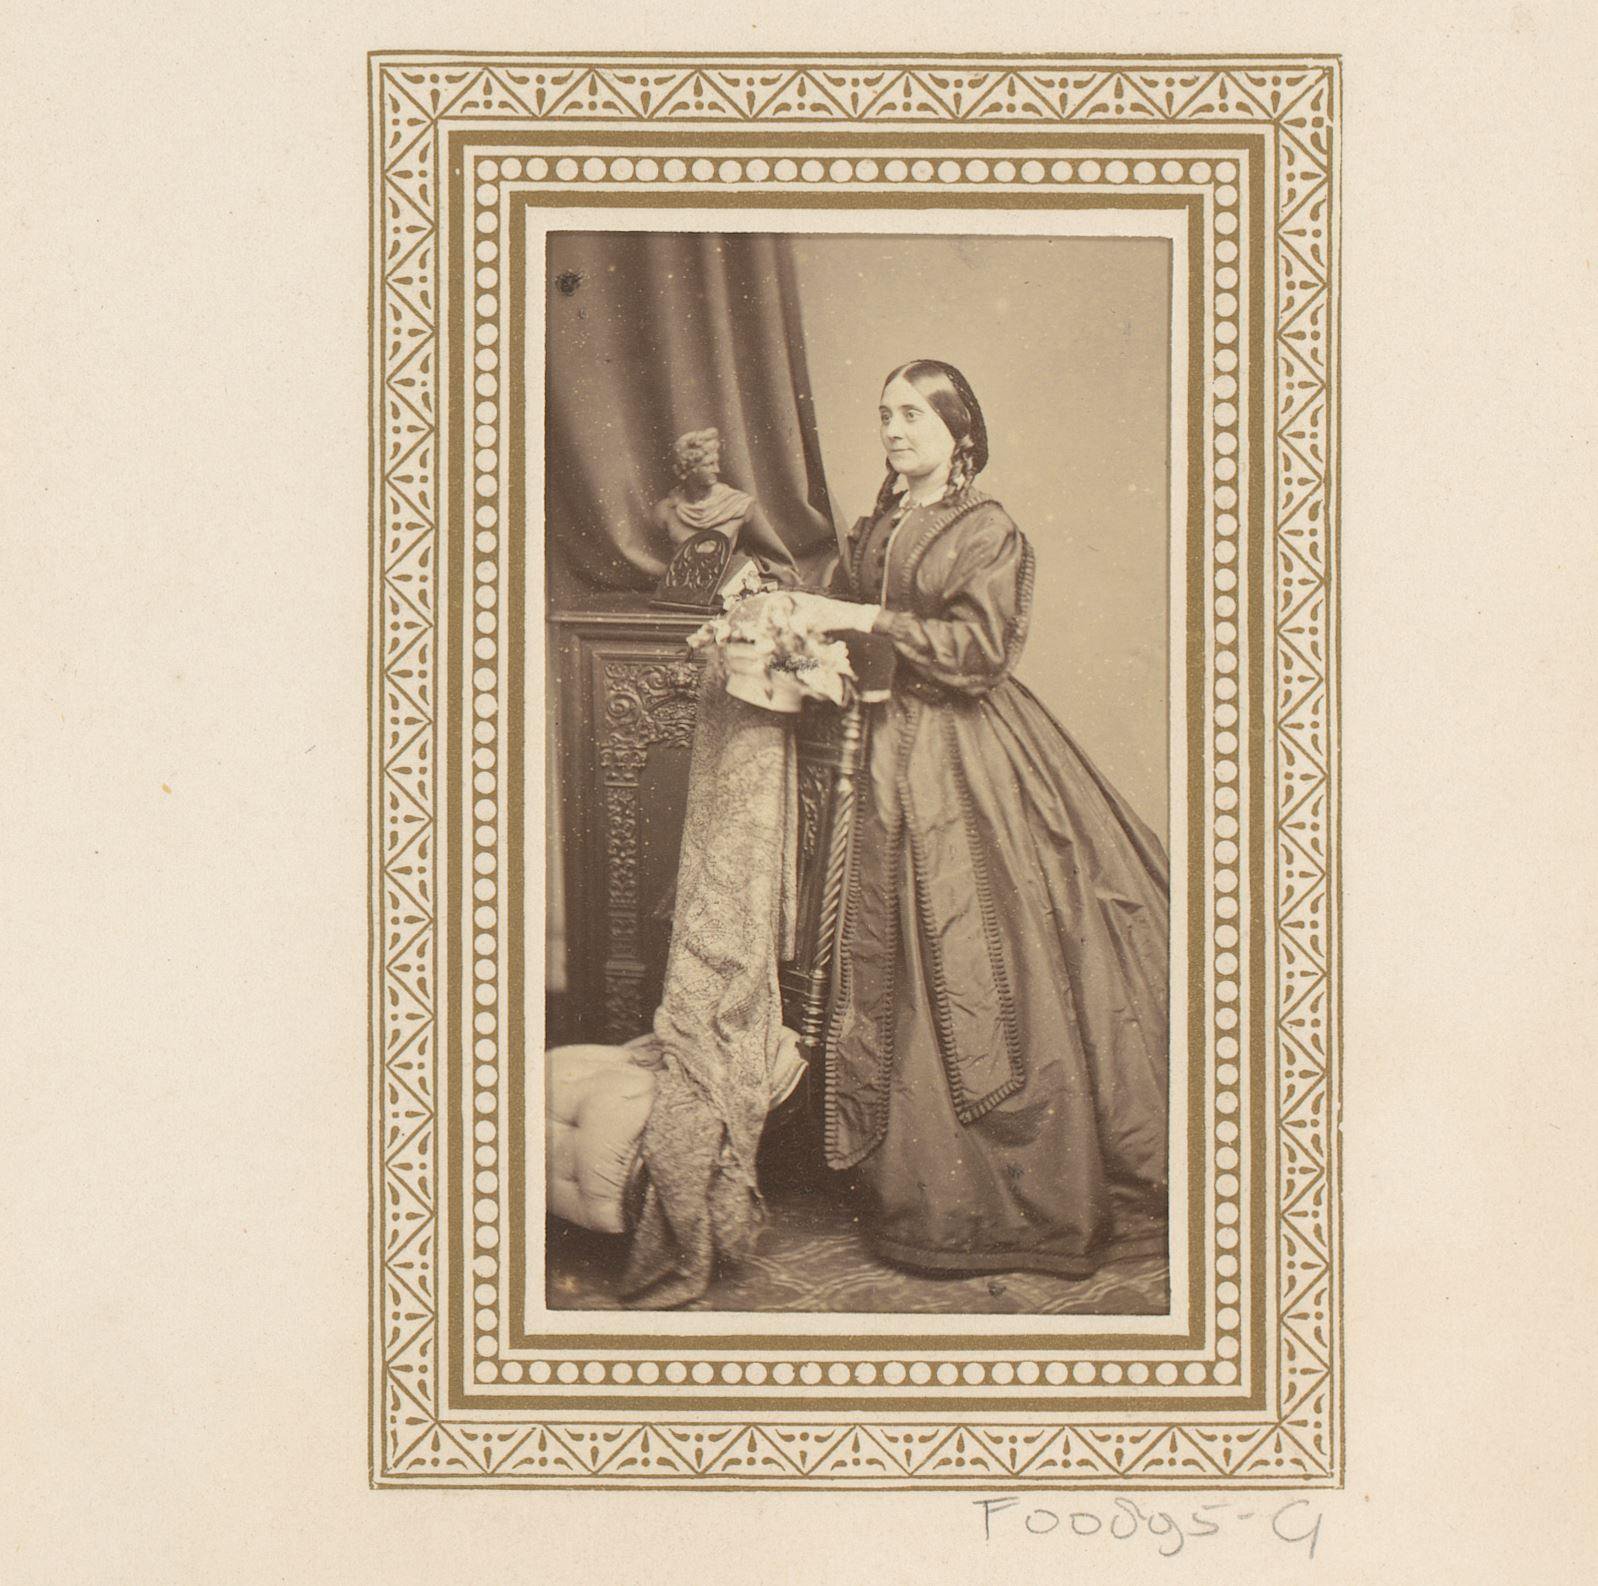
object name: album leaf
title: Portret van een staande vrouw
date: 1863-1875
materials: cardboard, photographic support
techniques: albumen print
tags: historical persons, standing figure - aa - female human figure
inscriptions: inscription: ‘G & R Lavis/ Photographers/ Minature Painters/ 135 Regent Street/ W.’